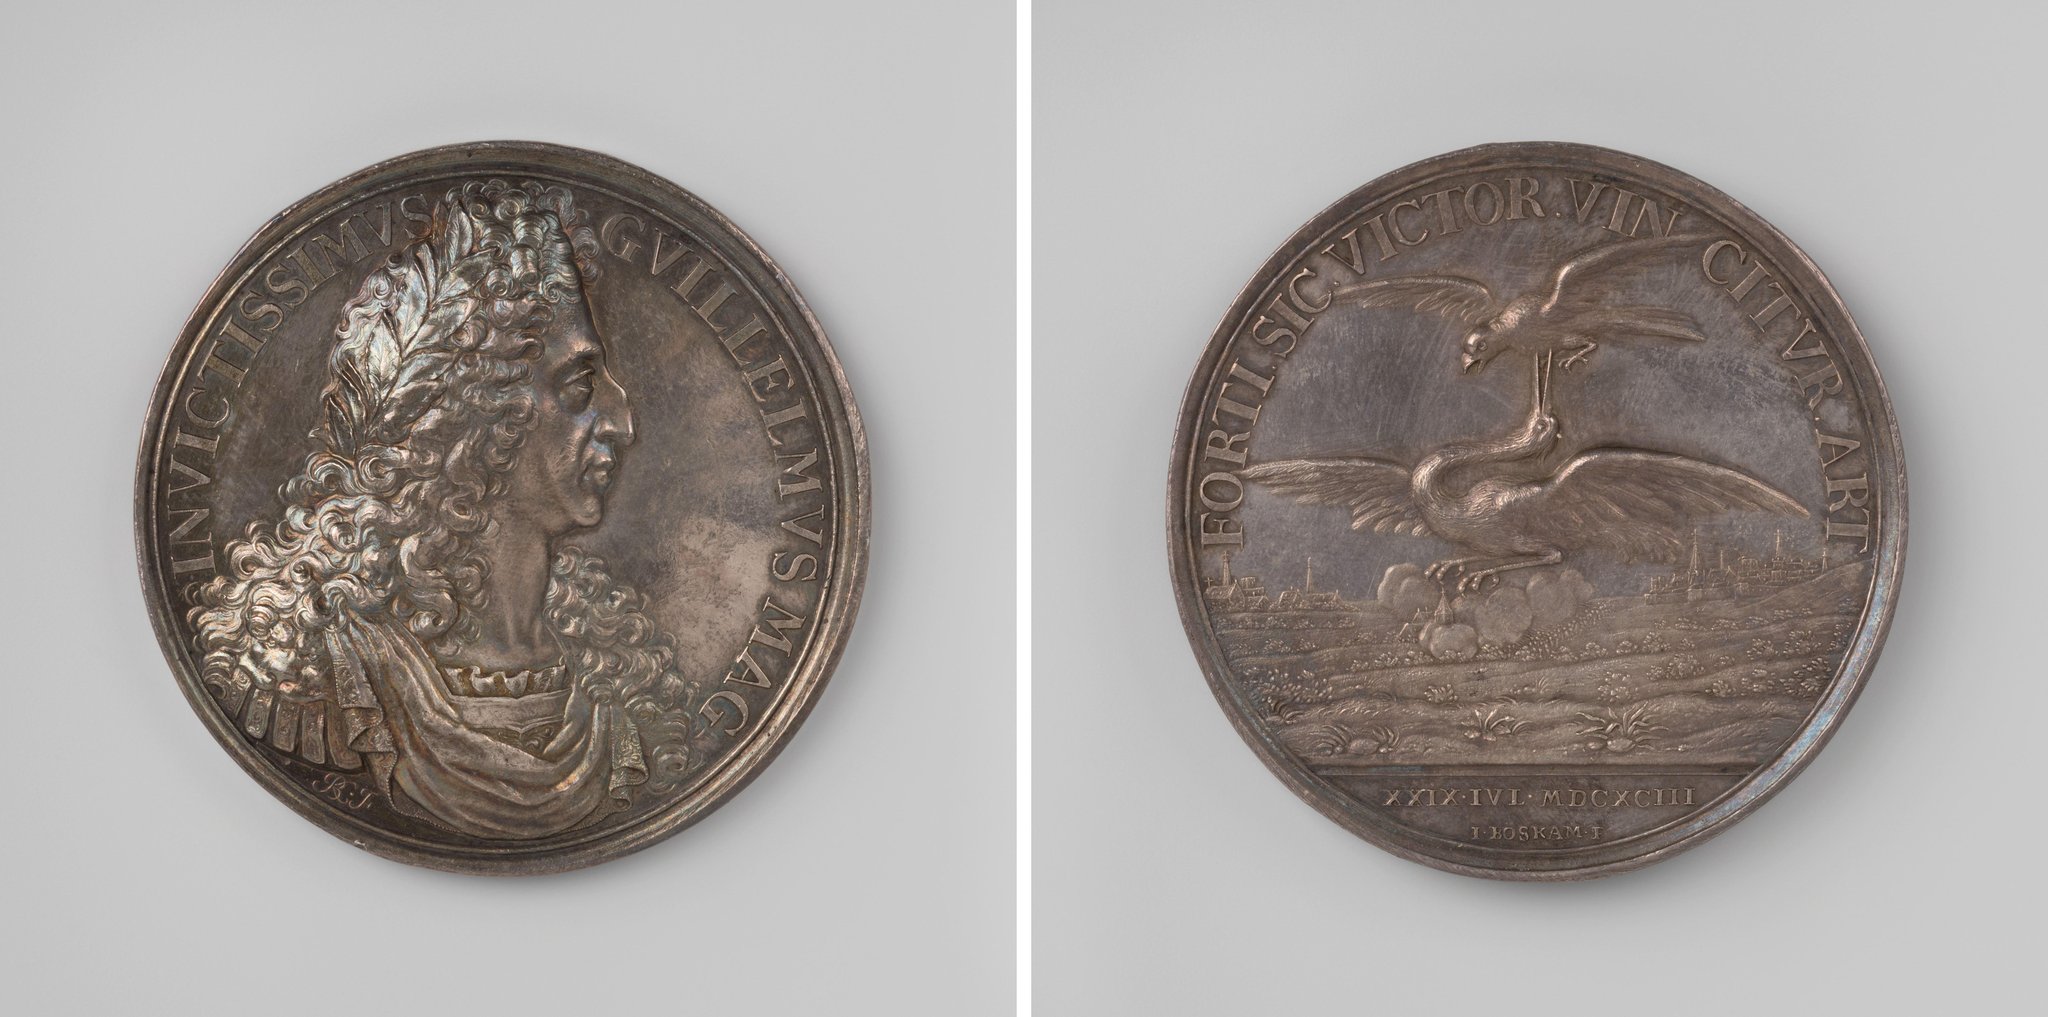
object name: history medal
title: Slag bij Neerwinden of Landen, ter ere van Willem III, prins van Oranje-Nassau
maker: jan boskam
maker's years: 1687-1708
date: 1693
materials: silver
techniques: striking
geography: nijmegen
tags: the hague, william iii (prince of orange and king of england, scotland, and ireland), brabant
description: Zilveren penning. Voorzijde: borststuk man met lauwerkrans binnen omschrift. Keerzijde: gevecht tussen valk en reiger in de lucht, op achtergrond slagveld binnen omschrift; afsnede: opschrift